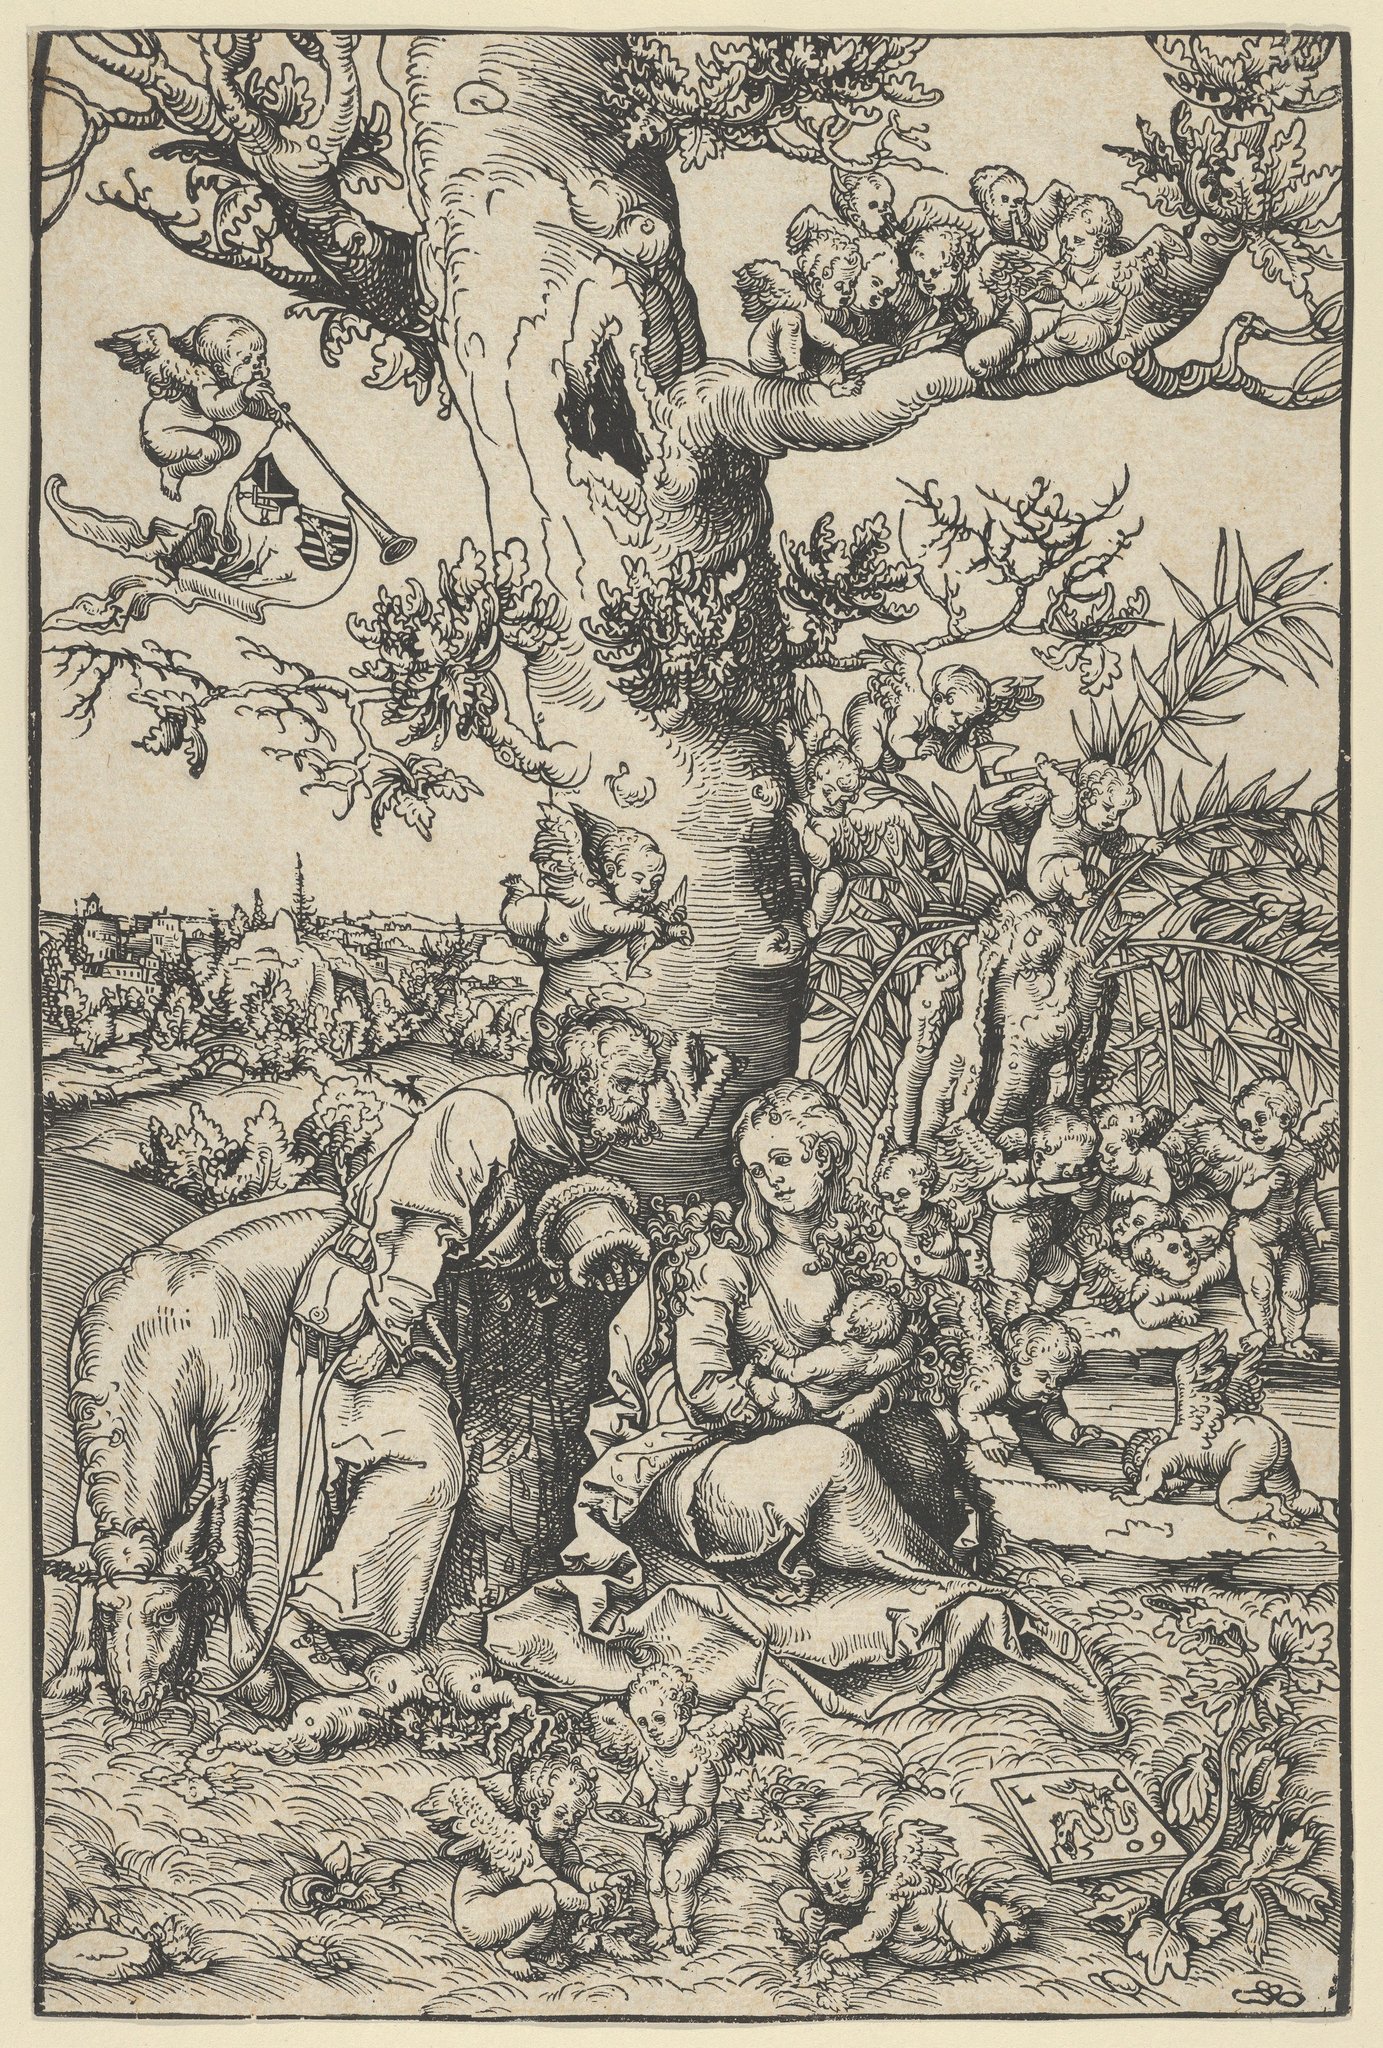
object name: print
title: Rest on the Flight into Egypt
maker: lucas cranach the elder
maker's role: artist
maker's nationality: german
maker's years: 1472-1553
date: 1509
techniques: woodcut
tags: animals,men,angels,madonna and child